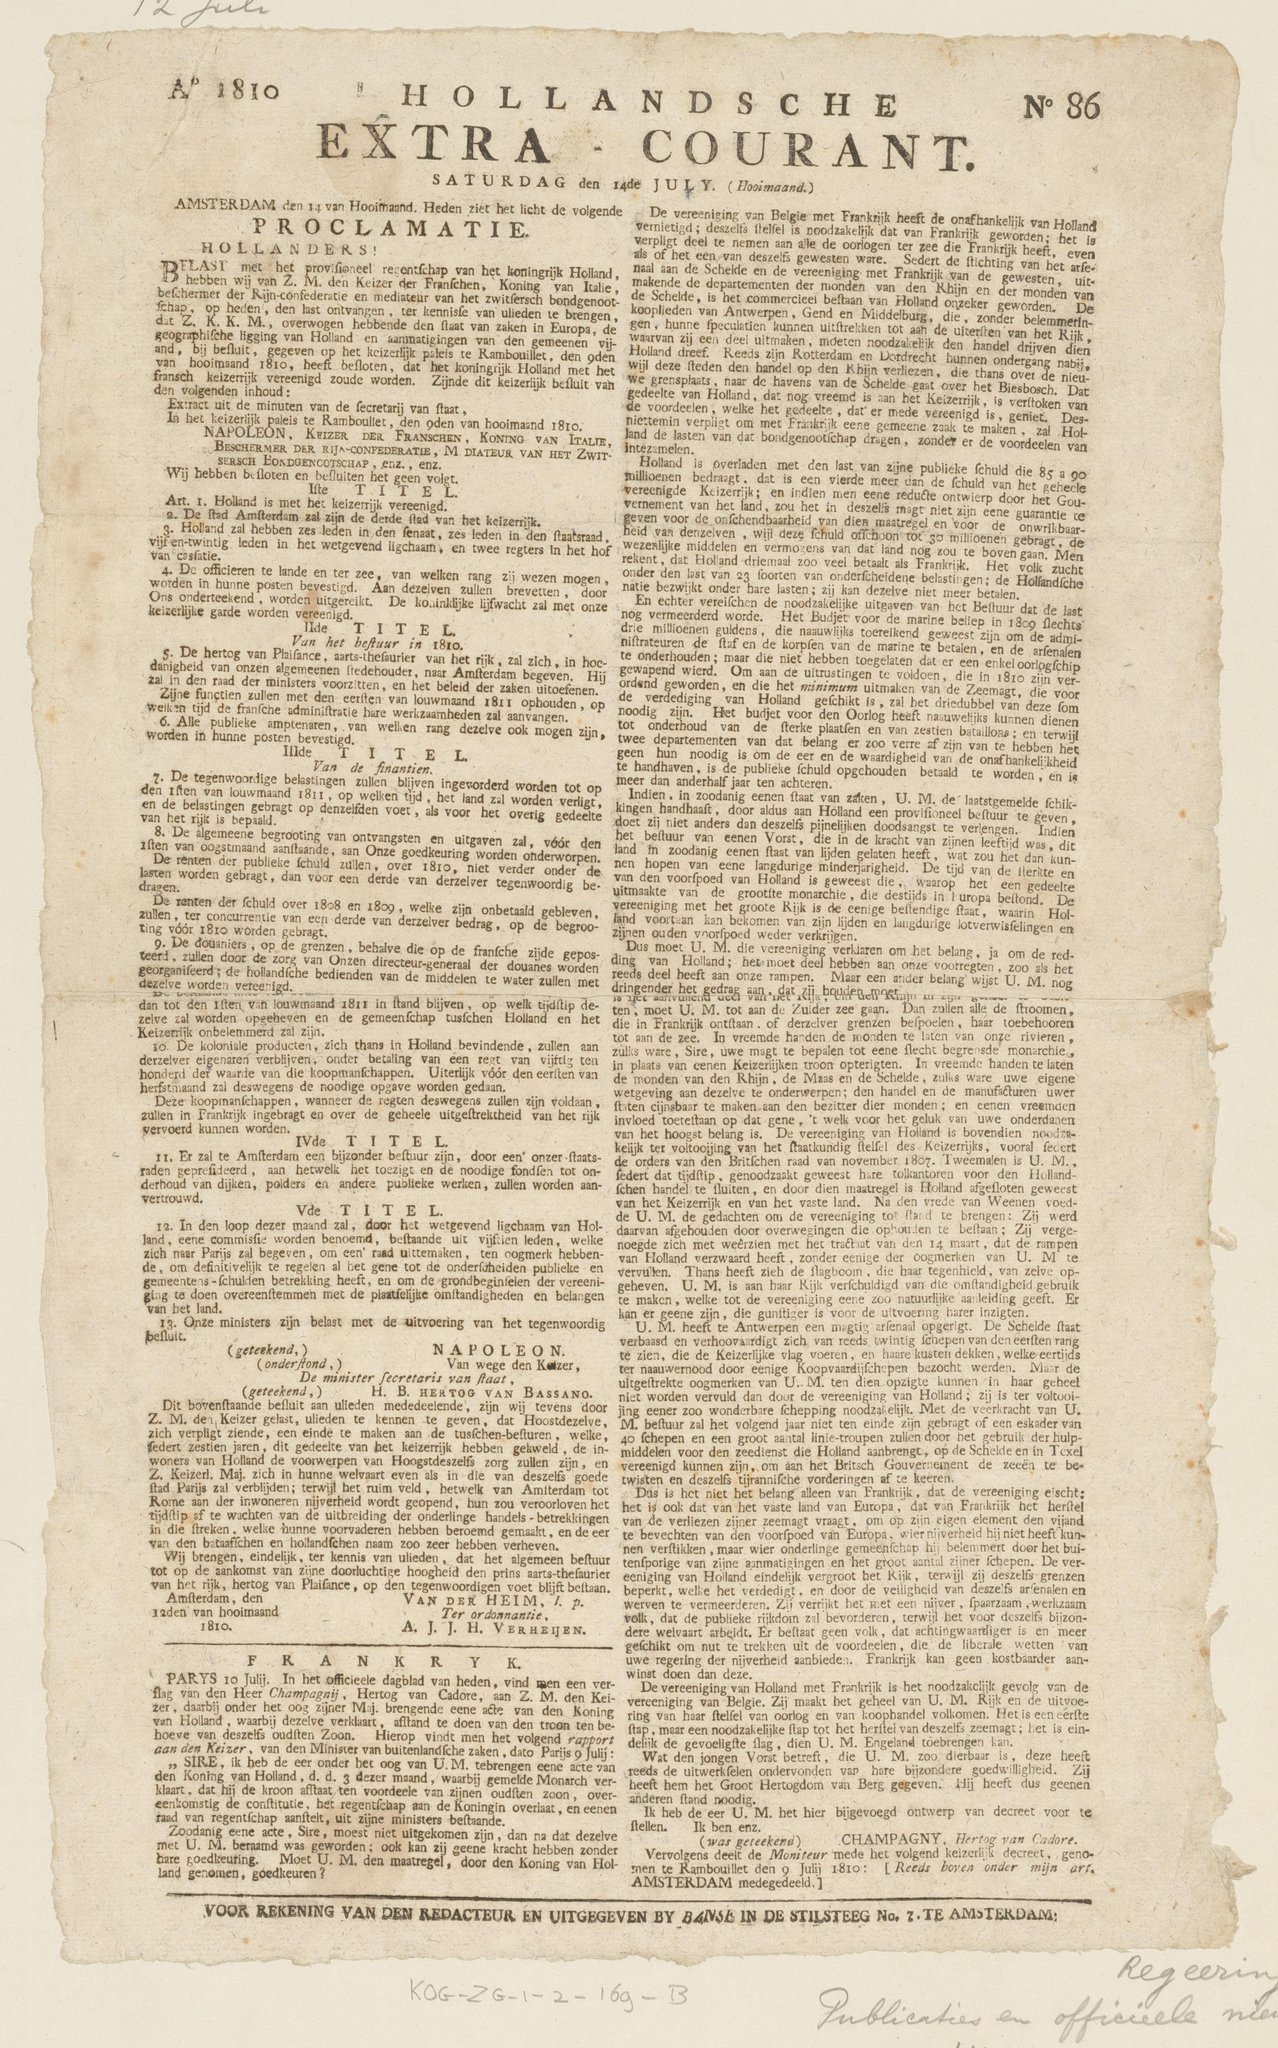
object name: newspaper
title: Hollandsche Extra-Courant, 14 juli 1810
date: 1810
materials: paper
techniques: letterpress printing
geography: amsterdam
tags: napoleon i (emperor of the french), emperor, newspaper, news-sheet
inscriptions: collector's mark: Lugt 1641, collector's mark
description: Exemplaar van de krant 'Hollandsche Extra-Courant' van 14 juli 1810, met de proclamatie van Napoleon Bonaparte over de inlijving van Holland bij het Franse keizerrijk. Gedrukte tekst. Onderwerpsrubrieken binnen de Atlas Zeden en Gewoonten: Regeering, Publicaties.